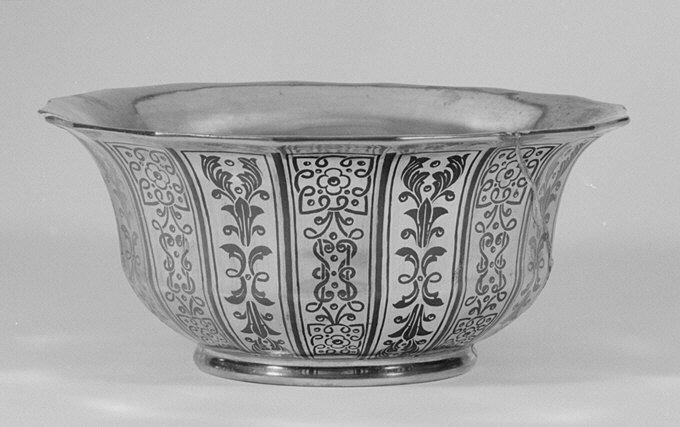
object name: bowl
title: Bowl (part of a coffee and tea service)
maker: imperial porcelain manufactory, st. petersburg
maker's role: manufactory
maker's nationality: russian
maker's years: 1744-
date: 1834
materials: hard paste porcelain